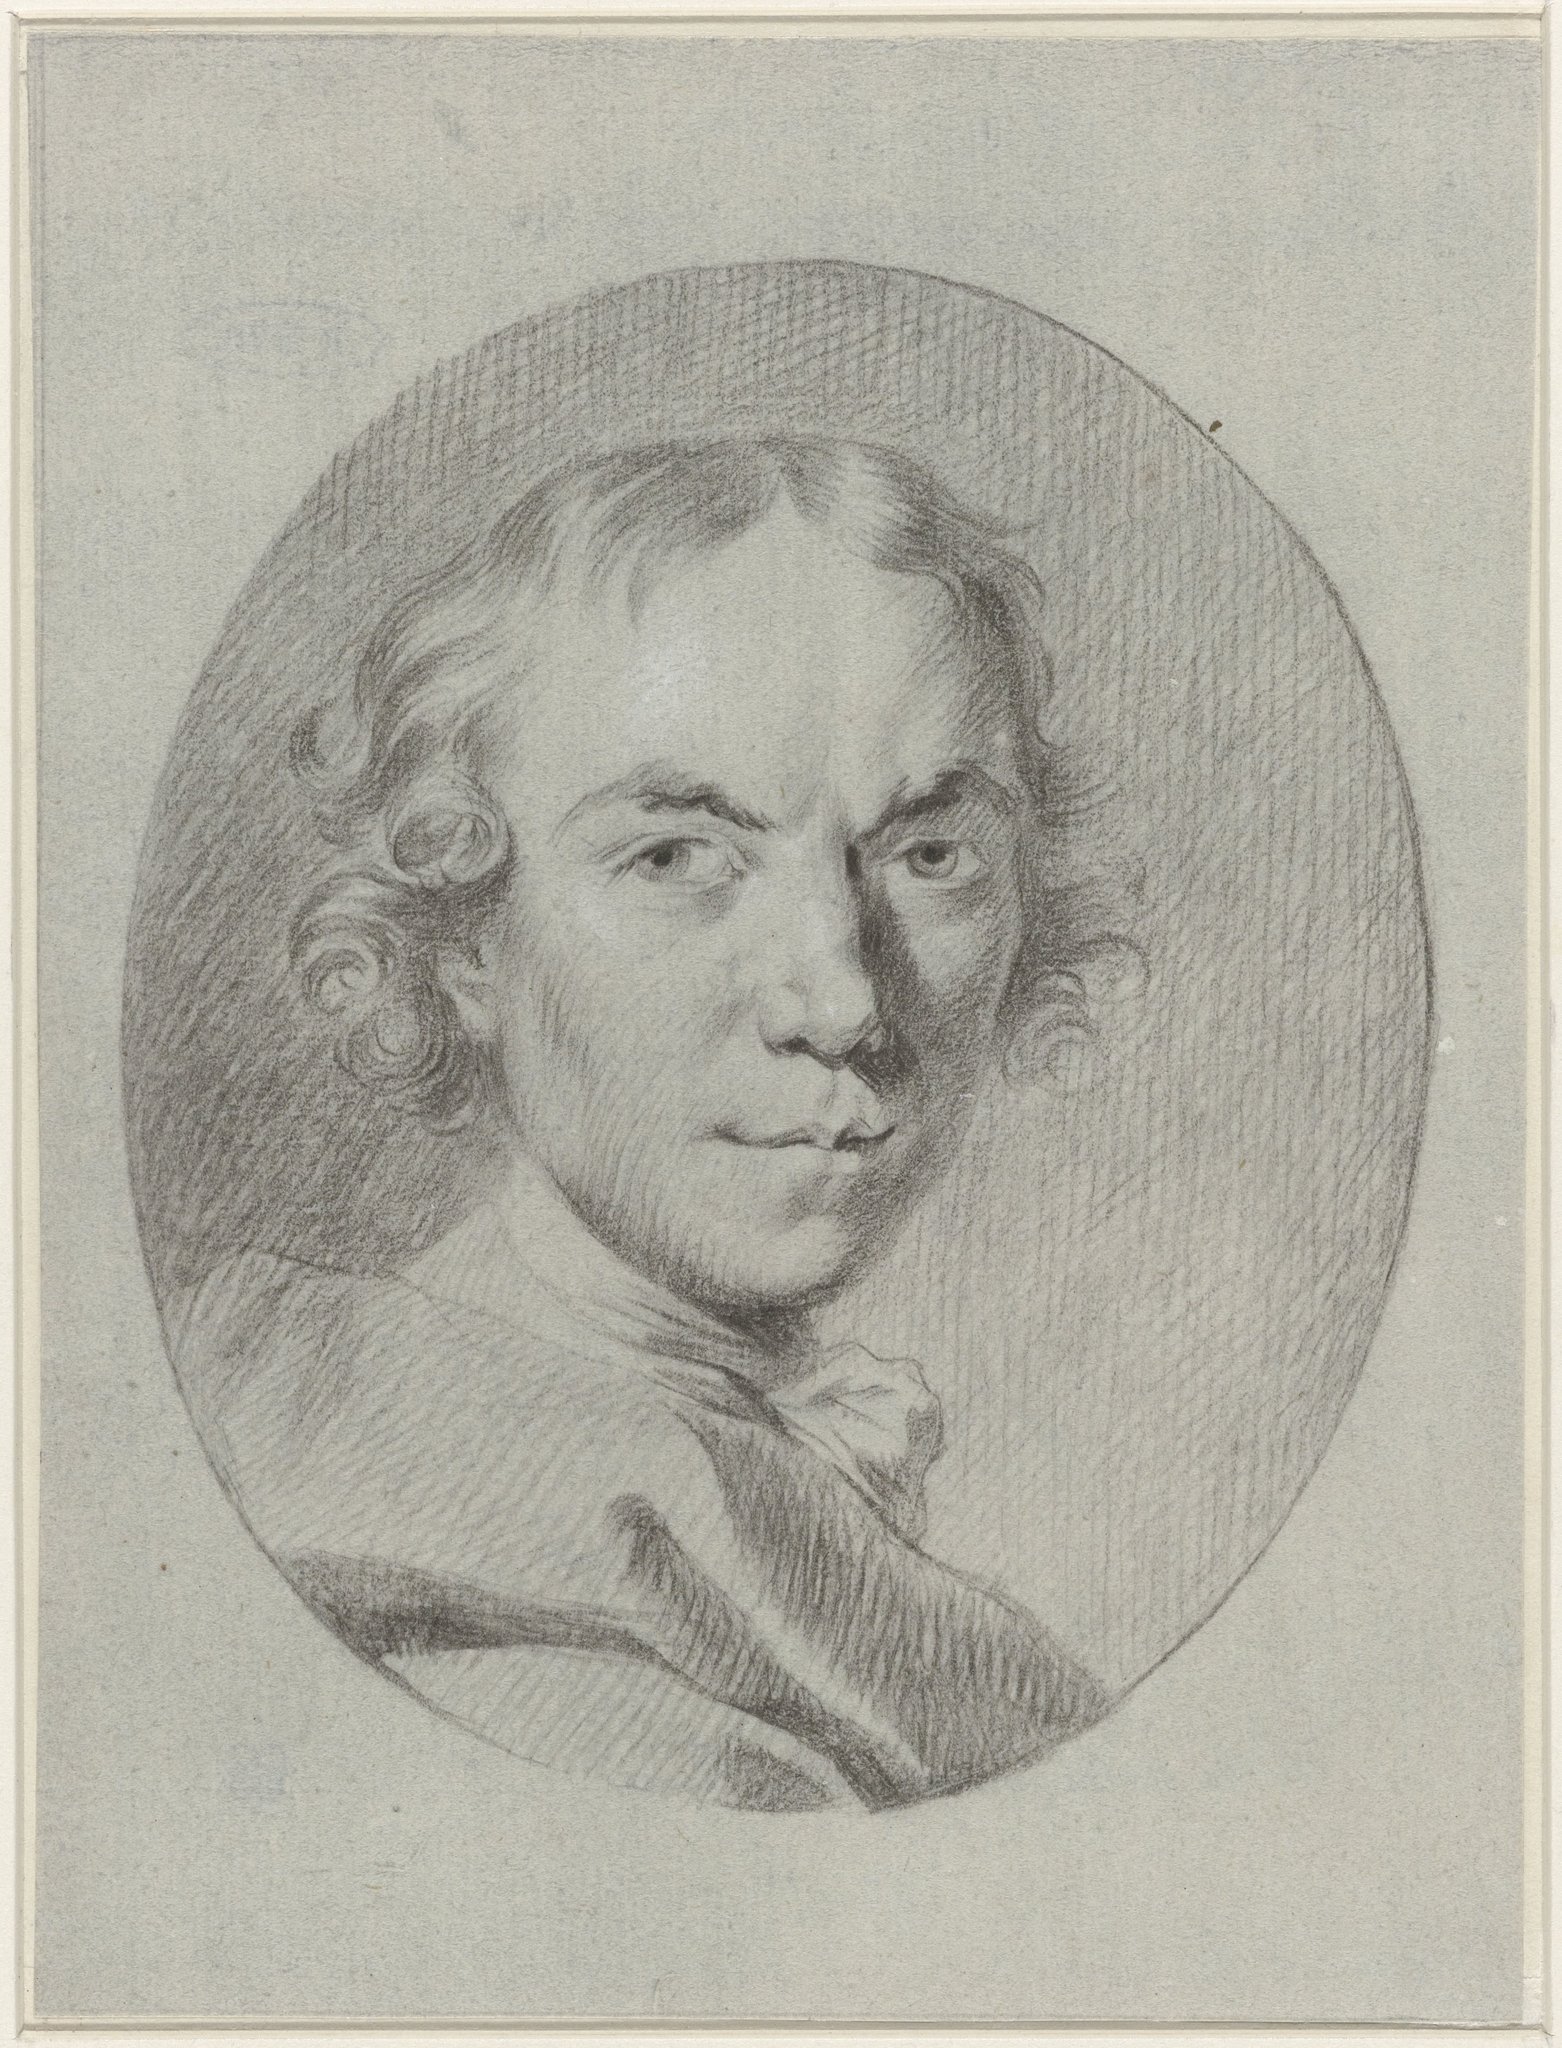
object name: drawing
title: Zelfportret van Louis de Moni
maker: louis de moni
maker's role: draughtsman, painter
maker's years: 1698-1771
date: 1772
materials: chalk, paper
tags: painter, louis de moni, historical persons, portrait, self-portrait of artist